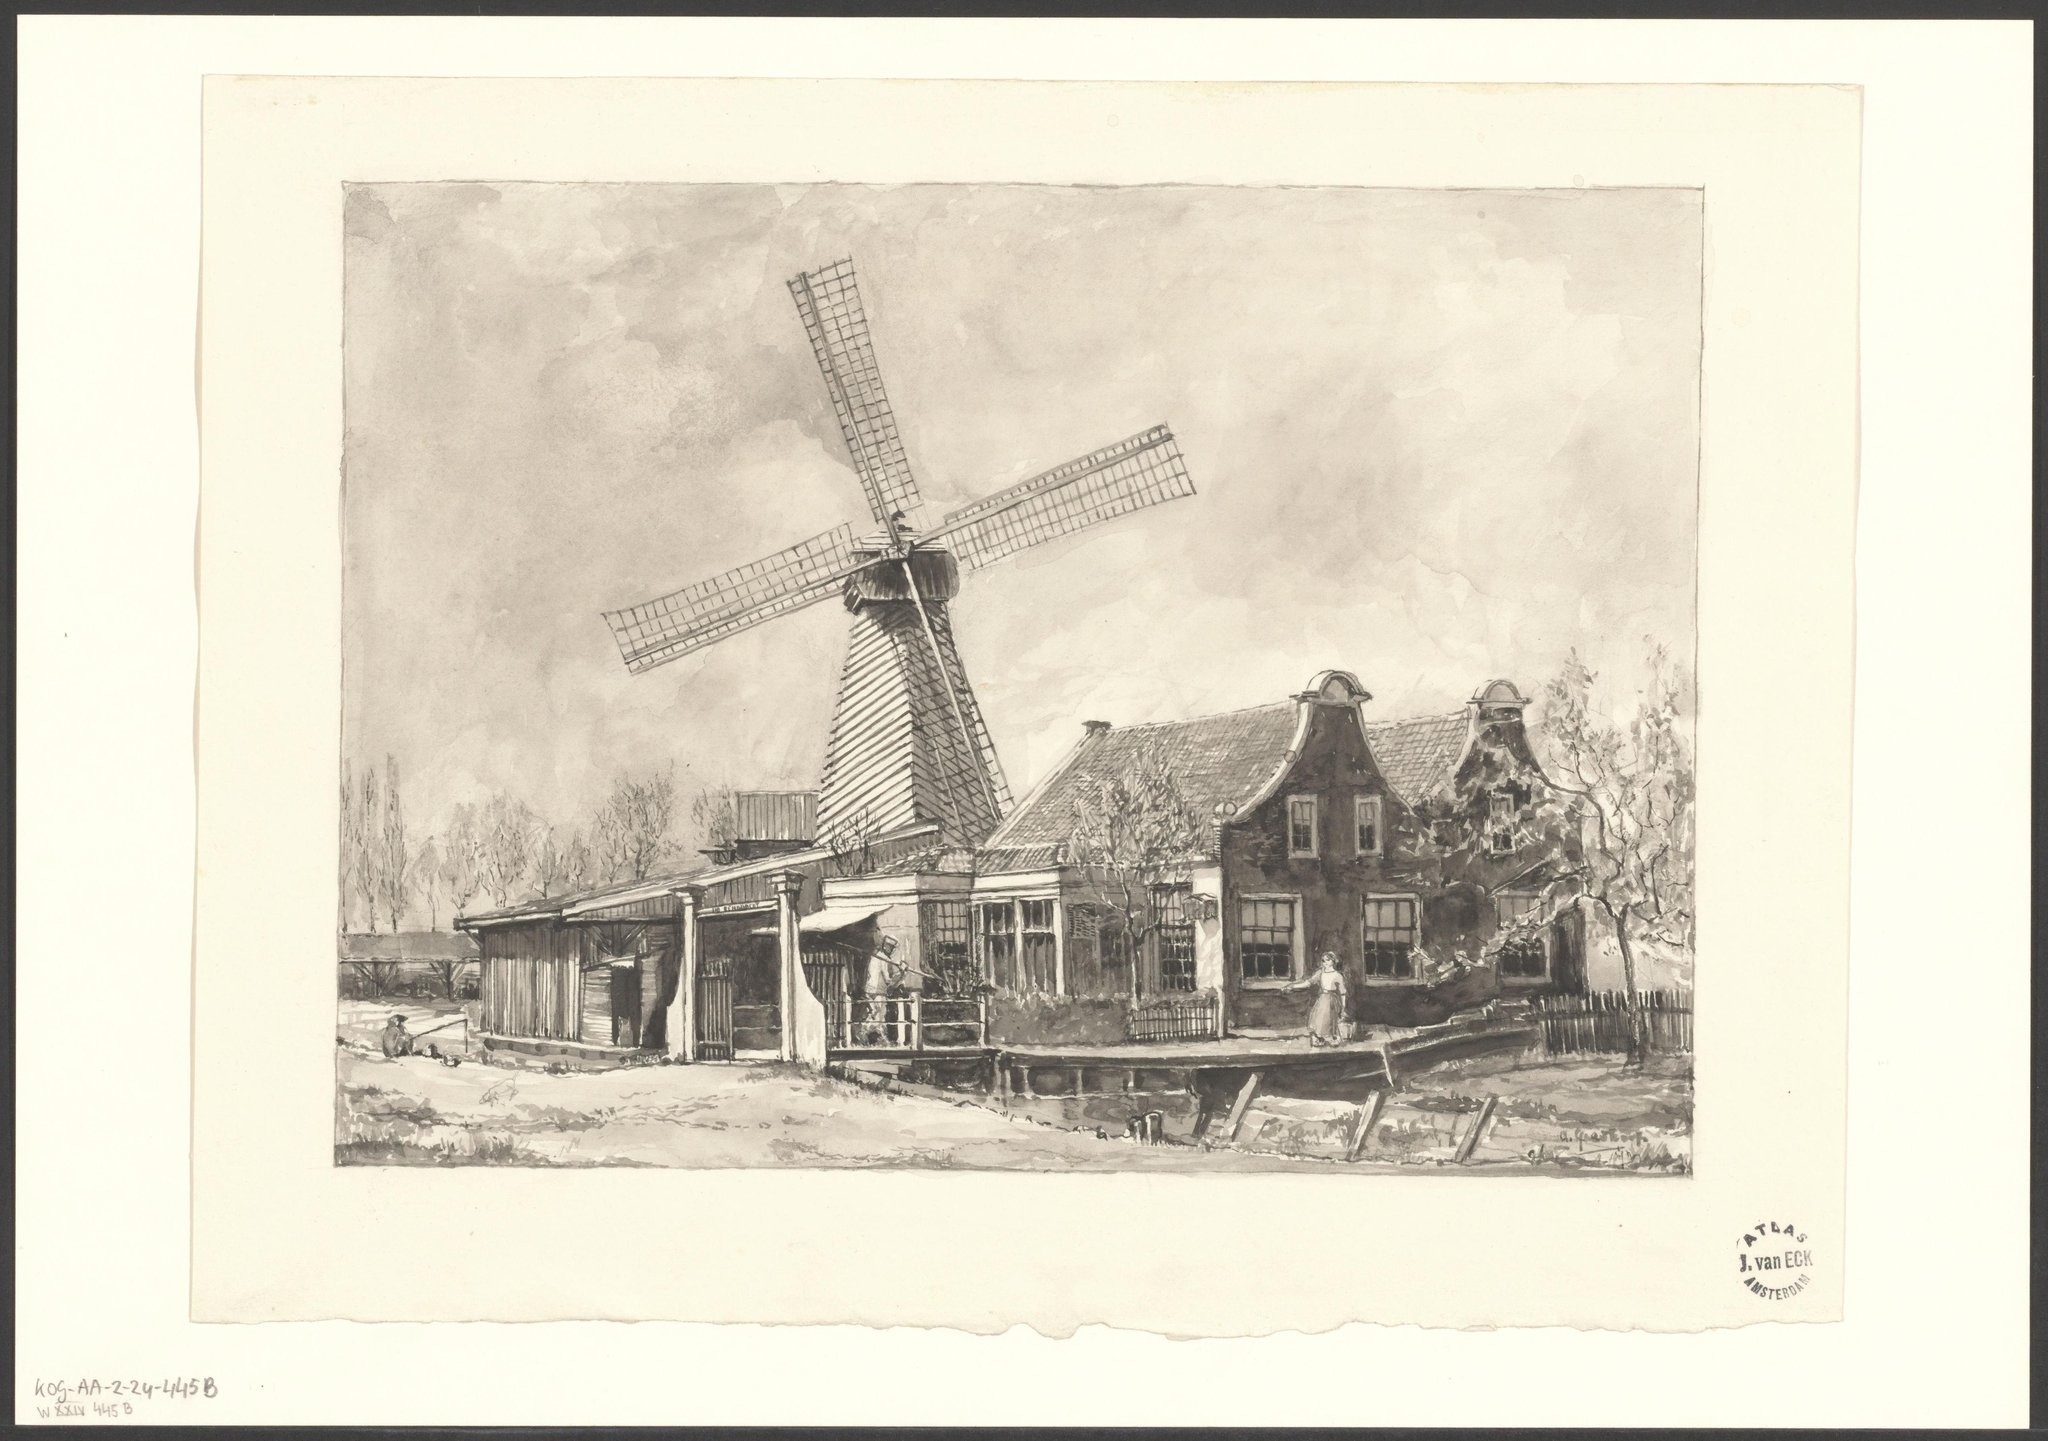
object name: drawing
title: Gezicht op de De Wittenkade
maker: goedkoop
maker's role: draughtsman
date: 1850-1950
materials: ink, paper, pencil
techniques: brush, pen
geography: amsterdam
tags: city-view in general; 'veduta', windmill in landscape, quay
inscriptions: collector's mark: Lugt 800a, signature: ‘a. goedkoop’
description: Tekening binnen de Atlas Van Eck ingedeeld op wijknummer 24.